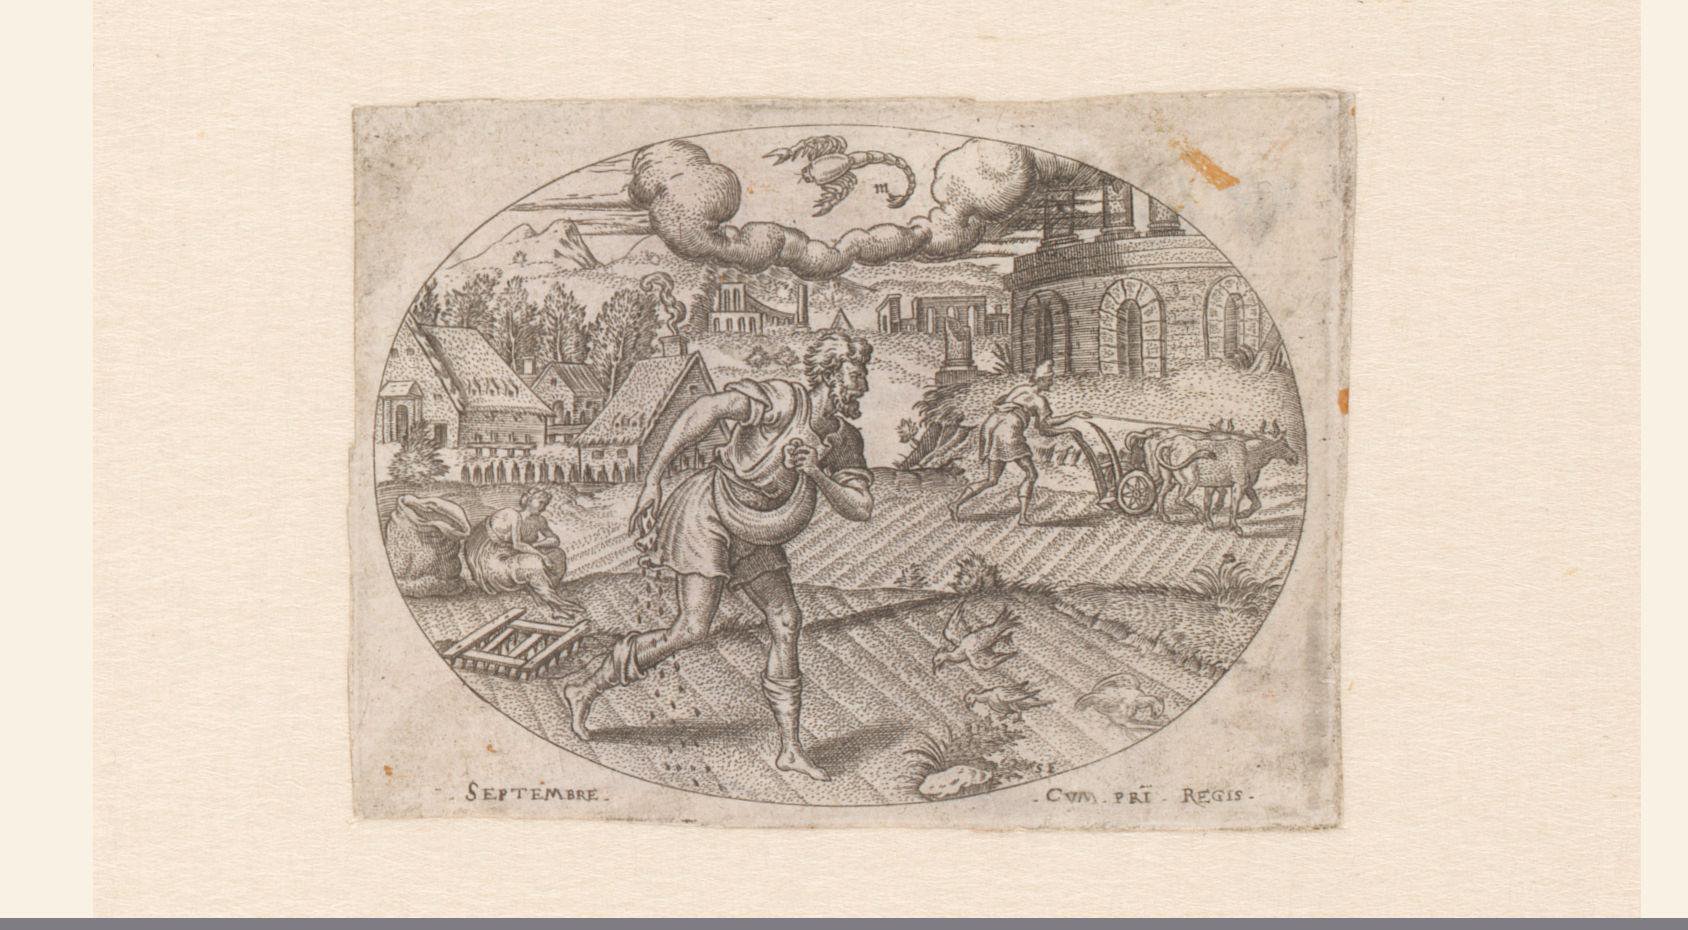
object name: print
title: Twaalf maanden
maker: etienne delaune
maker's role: draughtsman, goldsmith, print maker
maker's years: 1519-1583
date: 1568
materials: paper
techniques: engraving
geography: france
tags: scorpio (zodiacal sign of october), september and its 'labours' (+ with zodiacal signs)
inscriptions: collector's mark: Lugt 240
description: Maakt deel uit van een twaalfdelige serie van de twaalf maanden met tekens van de dierenriem, in ovale vorm. In de collectie van het Rijksmuseum bevindt zich de complete serie.